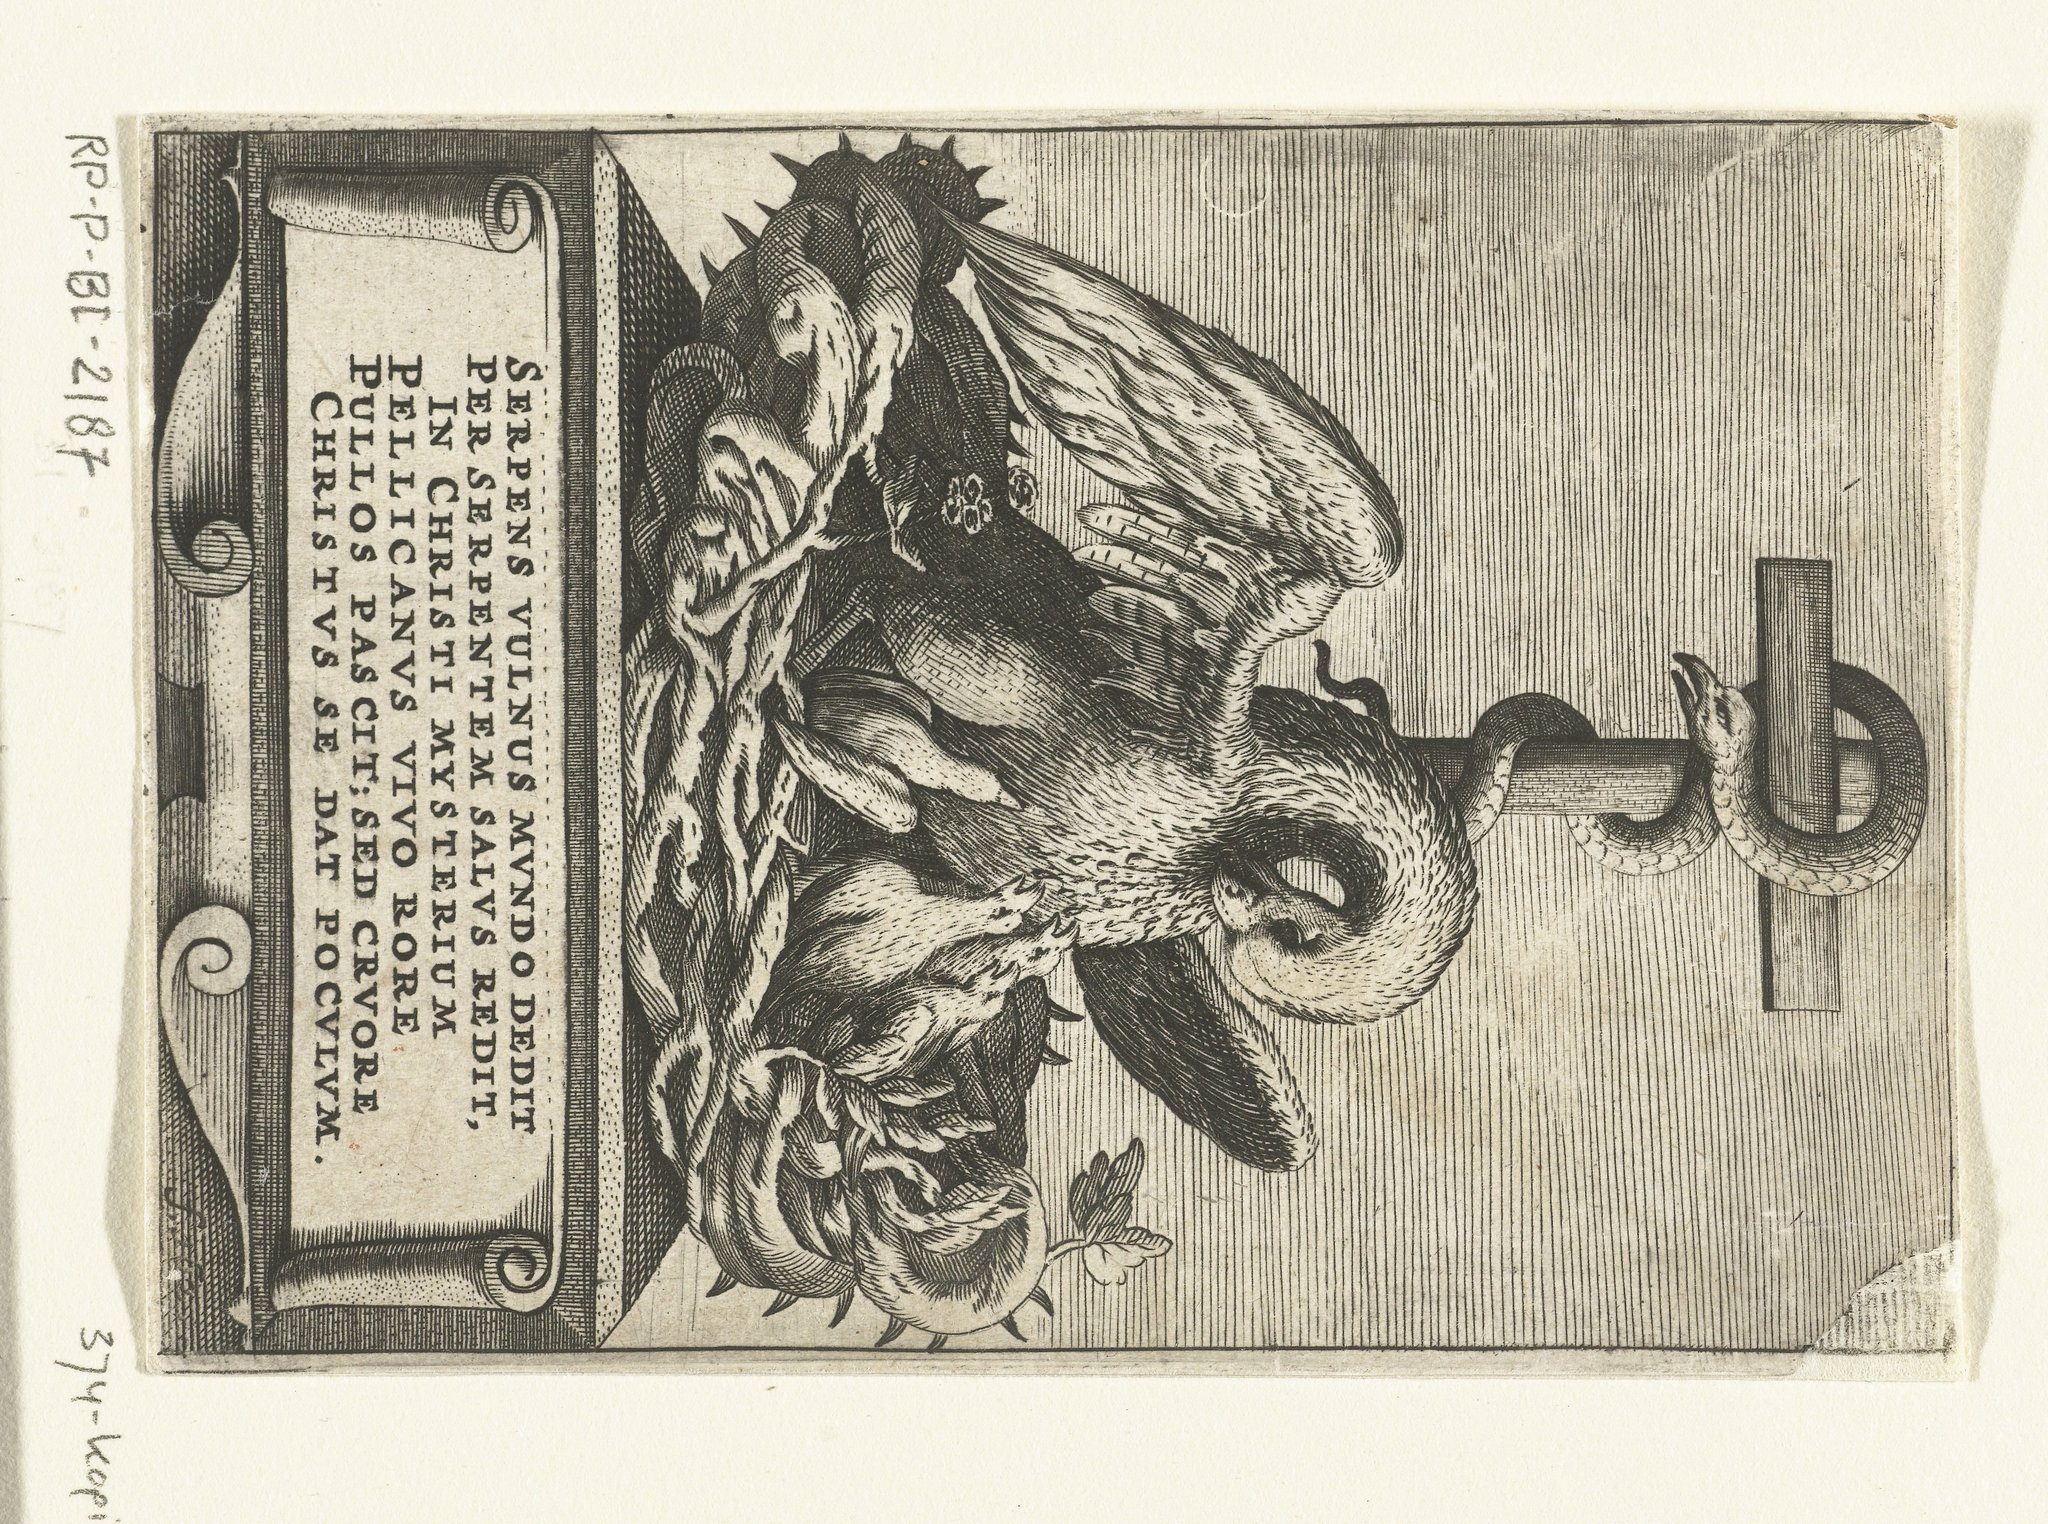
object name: print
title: Pelikaan voedt zijn jongen met zijn eigen bloed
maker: Anonymous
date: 1639-1689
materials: paper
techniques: engraving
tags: symbols of christ ~ animals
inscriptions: collector's mark: Lugt 240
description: Pelikaan als symbool van Christus nestelt in een doornenkroon en voedt zijn jongen met zijn eigen bloed. De vogel toont meer gelijkenis met een roofvogel zoals een adelaar. Een slang met een vogelkop krult zich om een kruis. In het verklarende vers wordt de vogel een pelikaan genoemd.